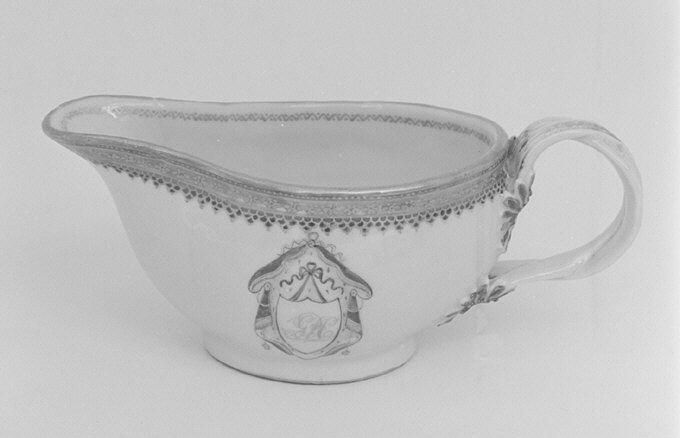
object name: sauceboat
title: Sauceboat (part of a service)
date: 1790-1800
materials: hard paste porcelain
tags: coat of arms